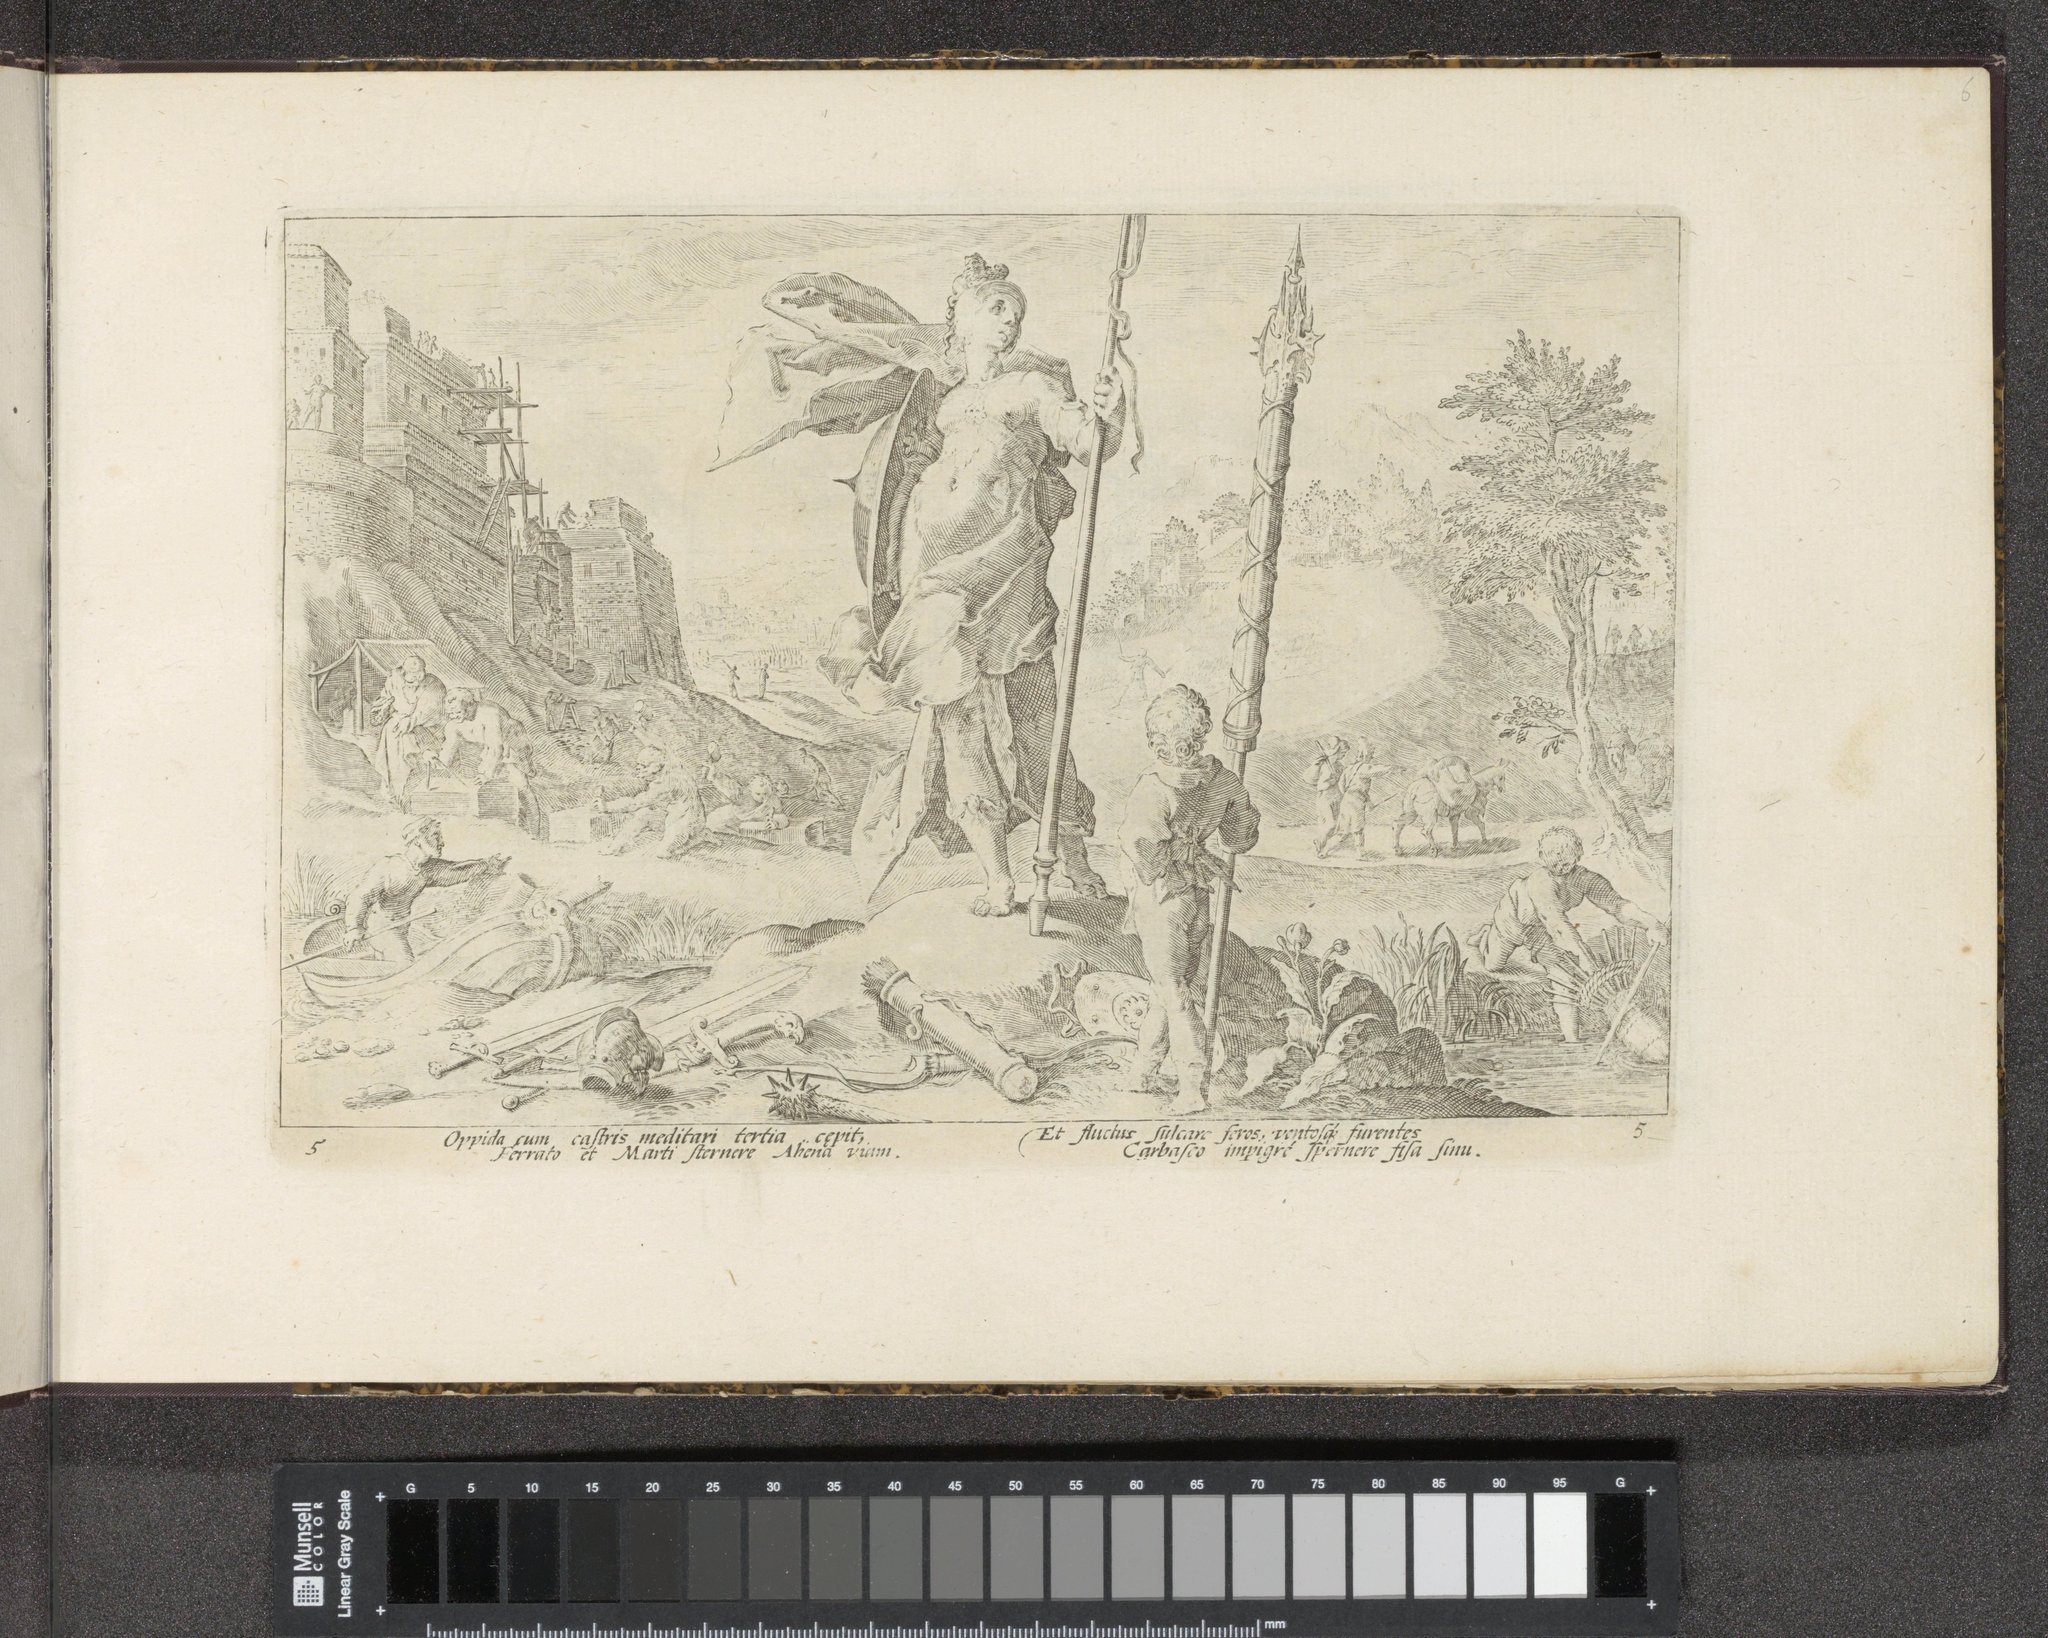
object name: album leaf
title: Herscheppingen van P. Ovidius Naso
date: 1589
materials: paper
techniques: engraving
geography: haarlem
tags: building activities, (story of) minerva (pallas, athena), weapons, fortifications, military engineering, the bronze age, 'aetas aenea'; characterized by minerva and building activities, weapons for striking a blow (with name)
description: Verbeelding van het leven tijdens de Bronzen Eeuw die ruiger van aard en men sneller klaarstond voor gevecht dan in de Zilveren Eeuw. Op de voorgrond staat Minerva met bij haar een jongen met een bundel steekwapens. Ook op de grond ligt allerlei wapentuigd: zwaarden, een helm en schild, een pijlenkoker en een morgenster. Links op de achtergrond bouwen mannen aan een verdedigingswerk of fort. Rechts trekt een jongen een eendenkorf uit het water. Onder de voorstelling twee keer twee versregels in het Latijn. De prent maakt deel uit van een album.